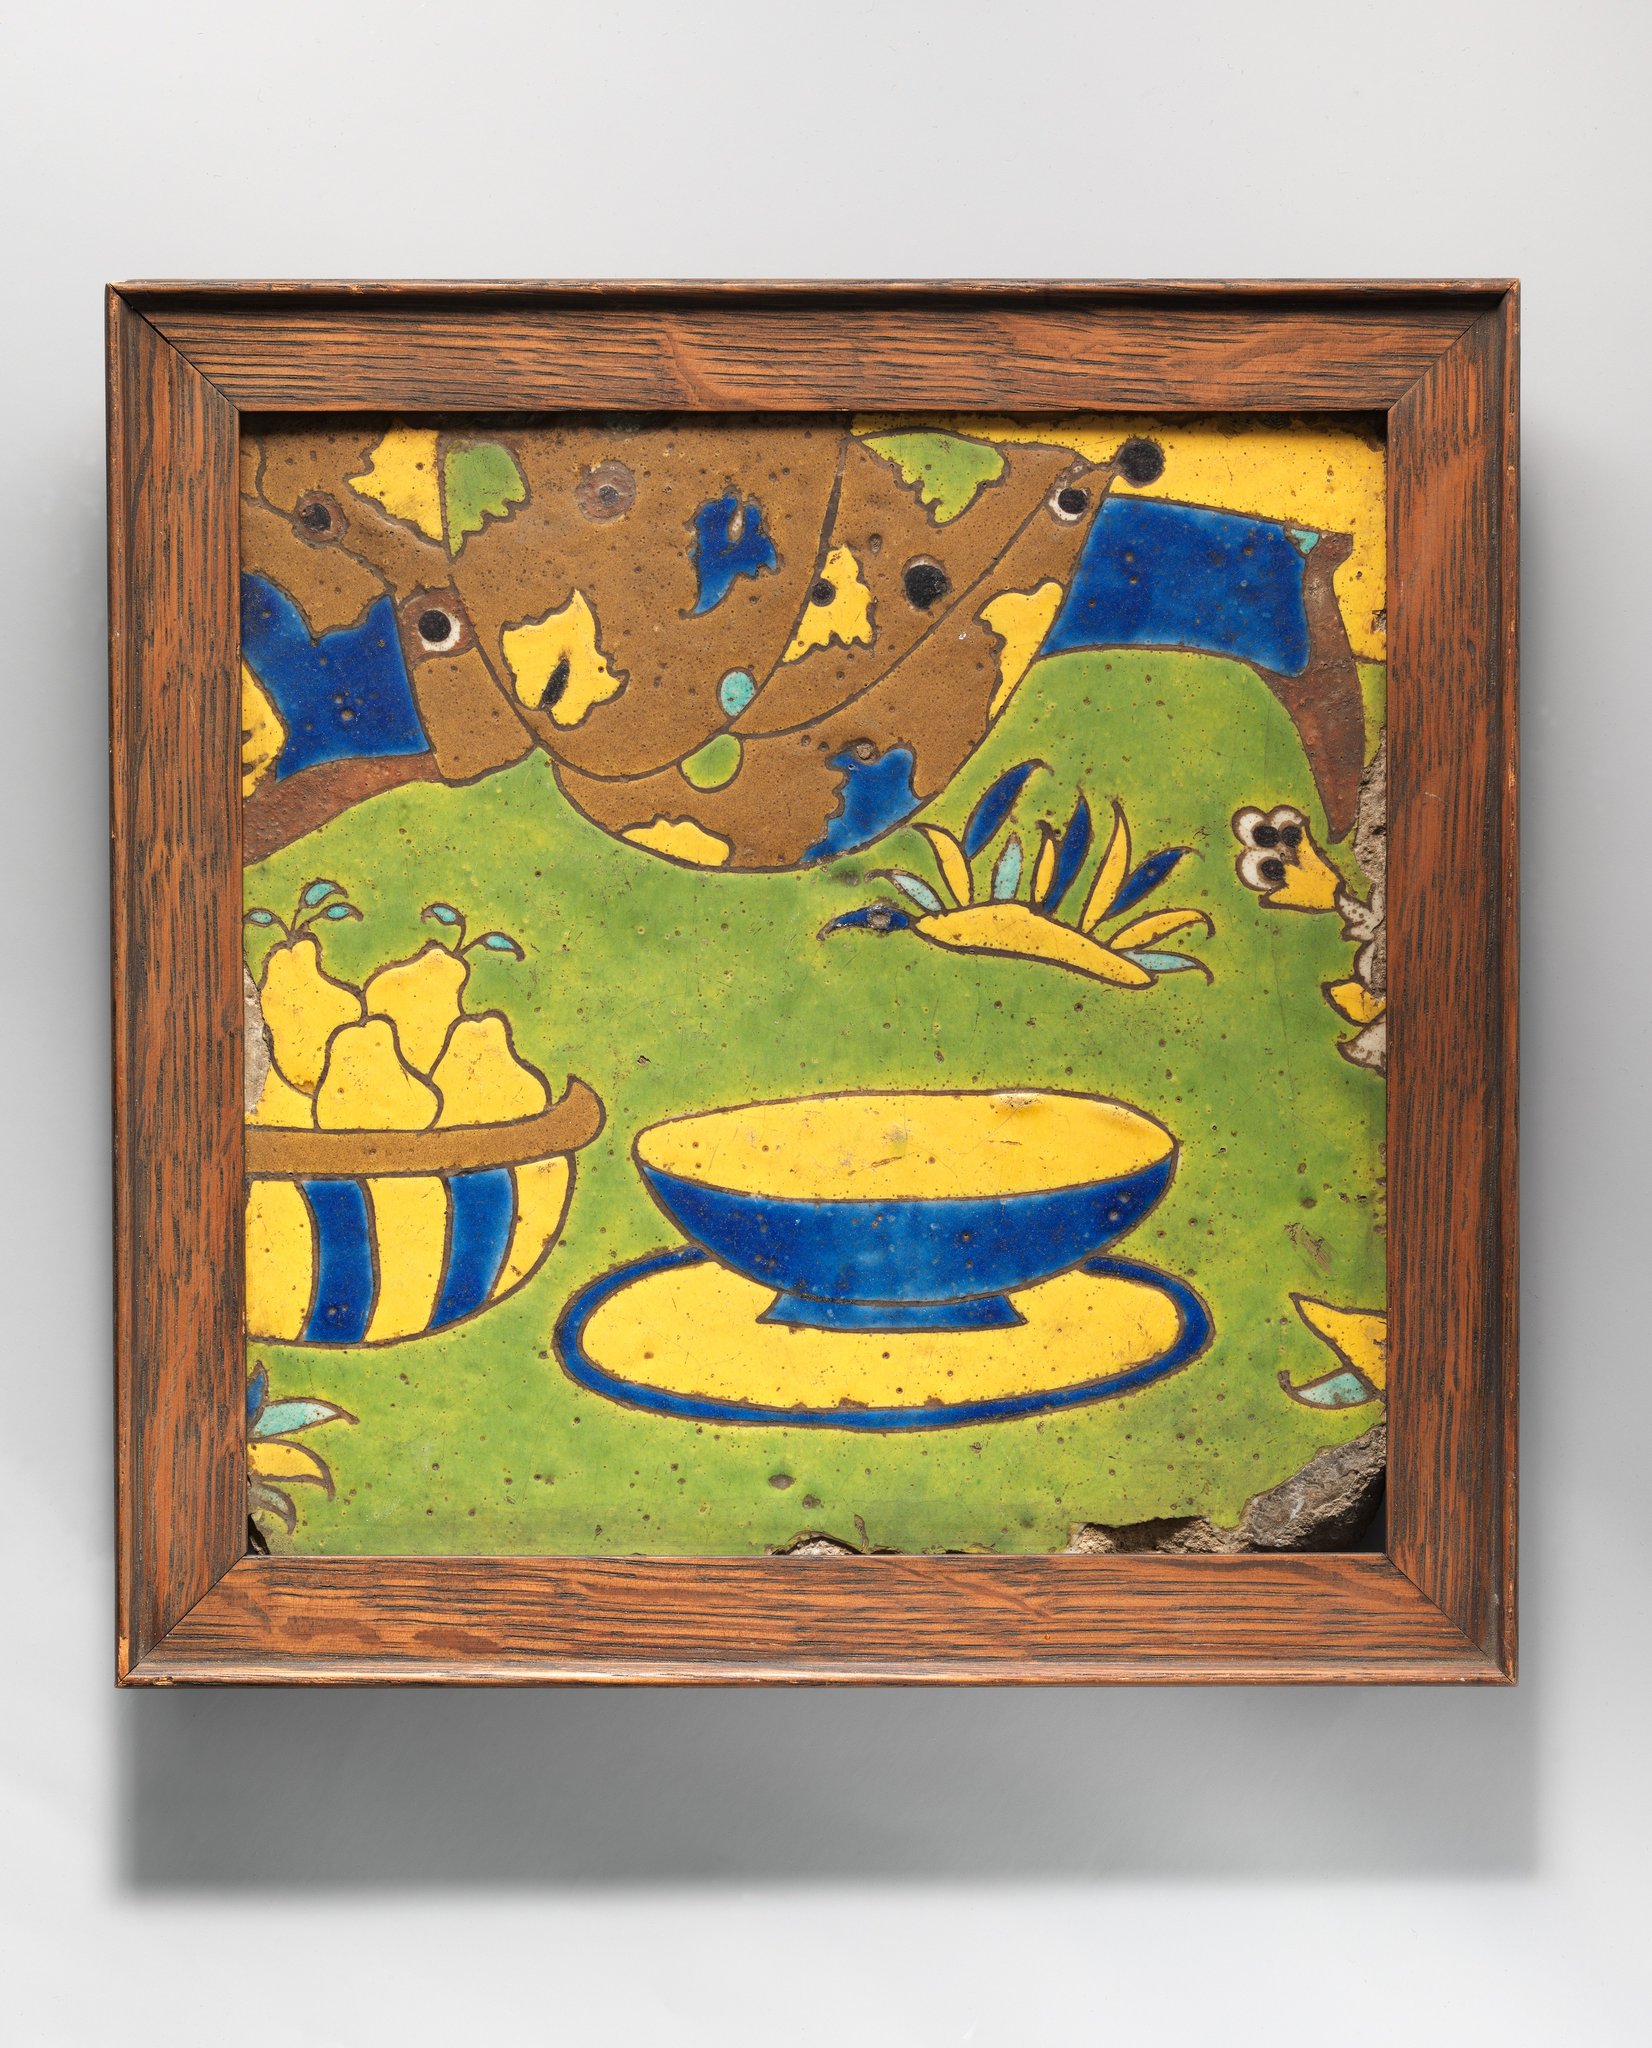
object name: tile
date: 1651-1700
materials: glaze, stonepaste, wax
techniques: polychrome, resist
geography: iran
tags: fruit